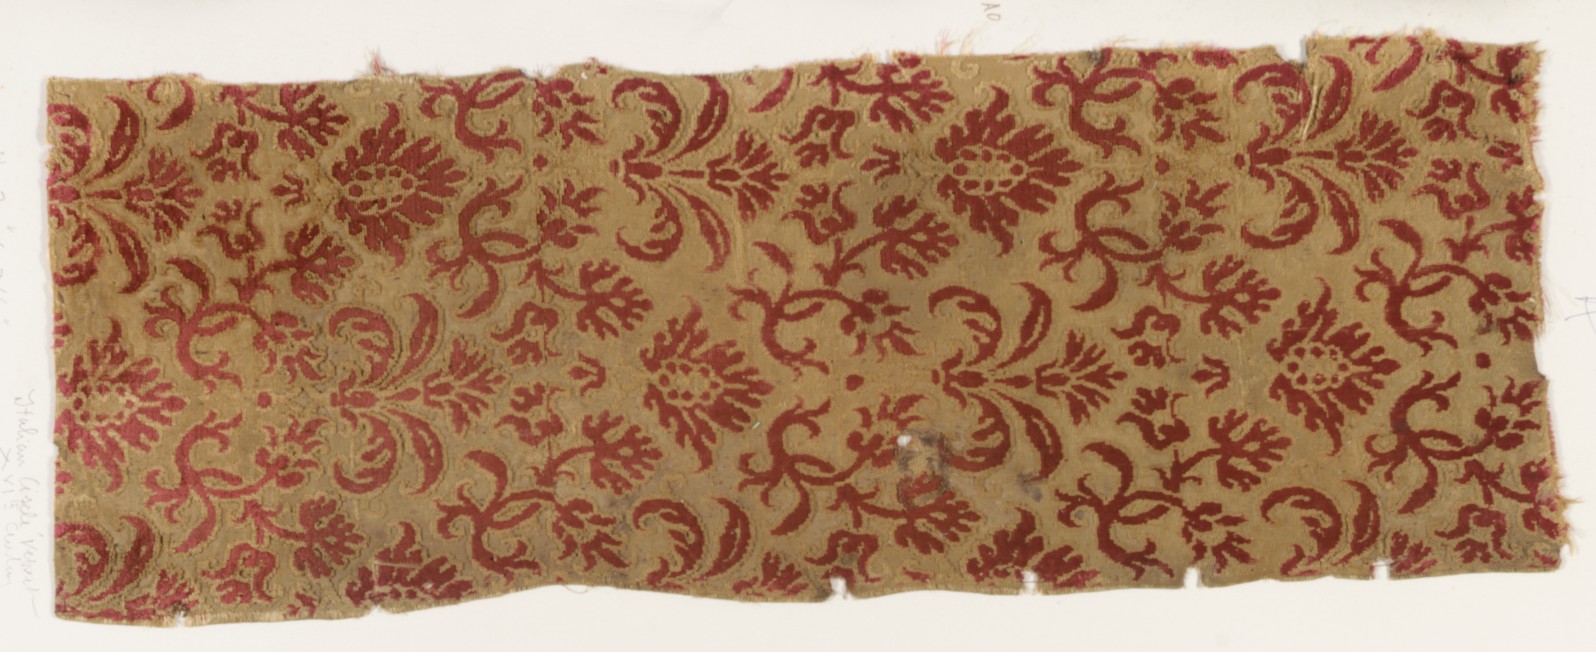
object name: fragment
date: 1501-1600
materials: silk